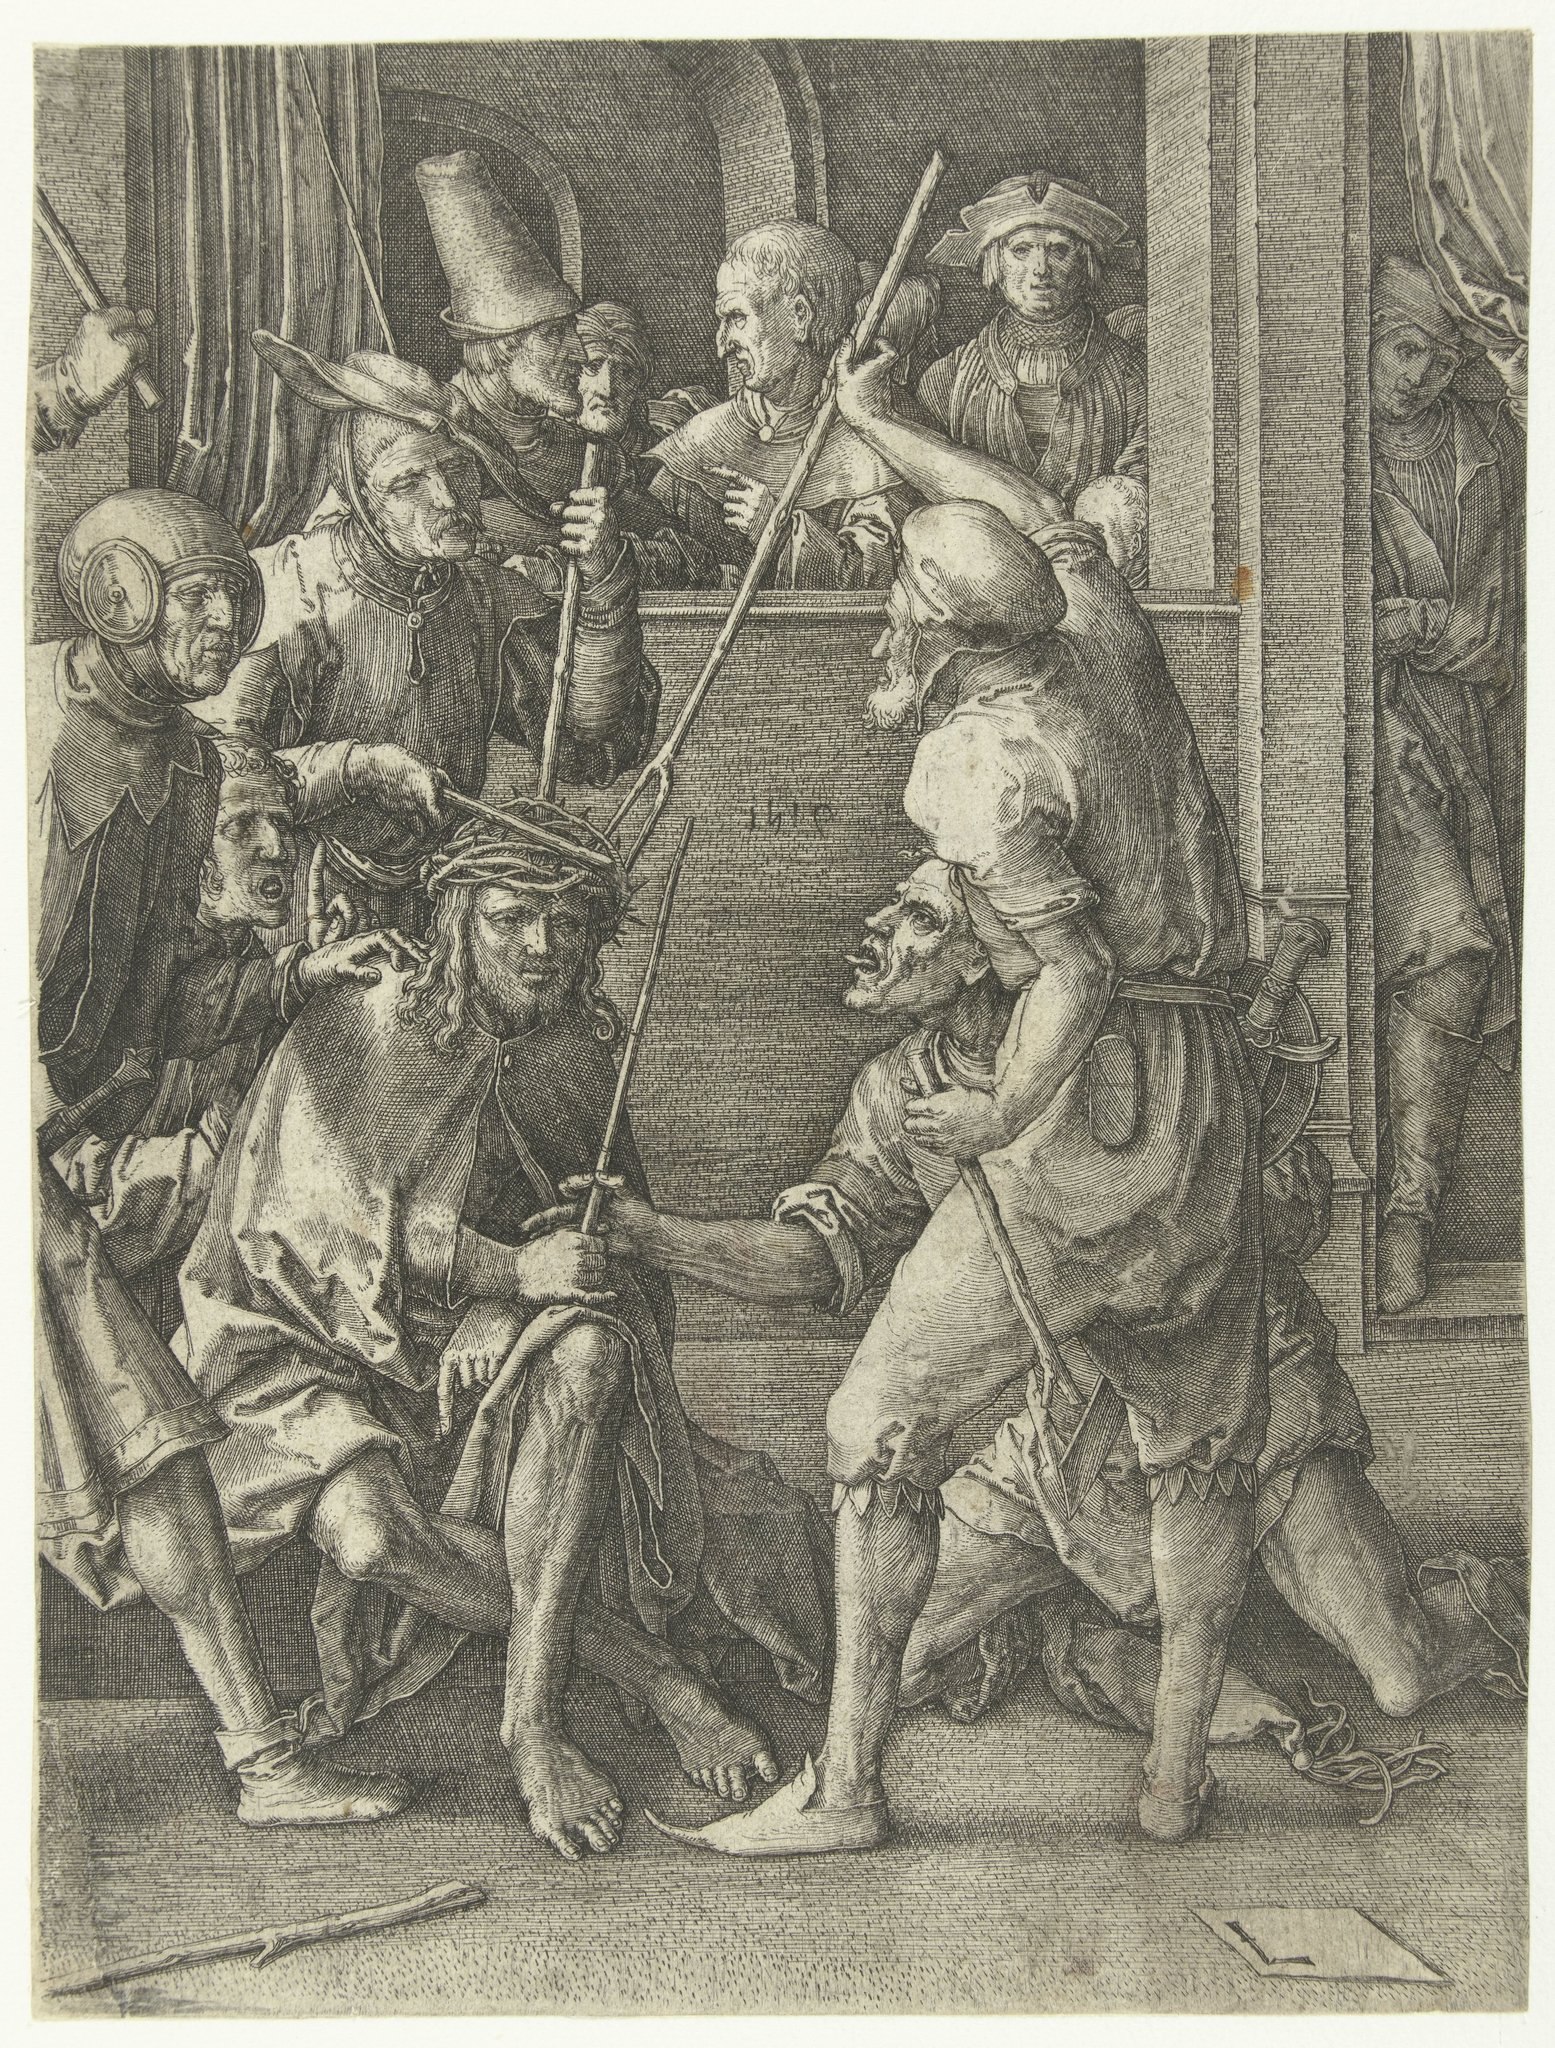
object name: print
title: Doornenkroning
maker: lucas van leyden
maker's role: draughtsman, painter, print maker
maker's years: 1494-1533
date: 1519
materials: paper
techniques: engraving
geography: low countries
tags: the crowning with thorns: soldiers with sticks place a thorny crown on christ's head and give him a reed (matthew 27:27-31; mark 15:16-20; john 19:2-3)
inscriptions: collector's mark: Lugt 2228a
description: Christus zittend op de grond, wordt door mannen een doornenkroon op het hoofd geduwd en een staf in de hand.